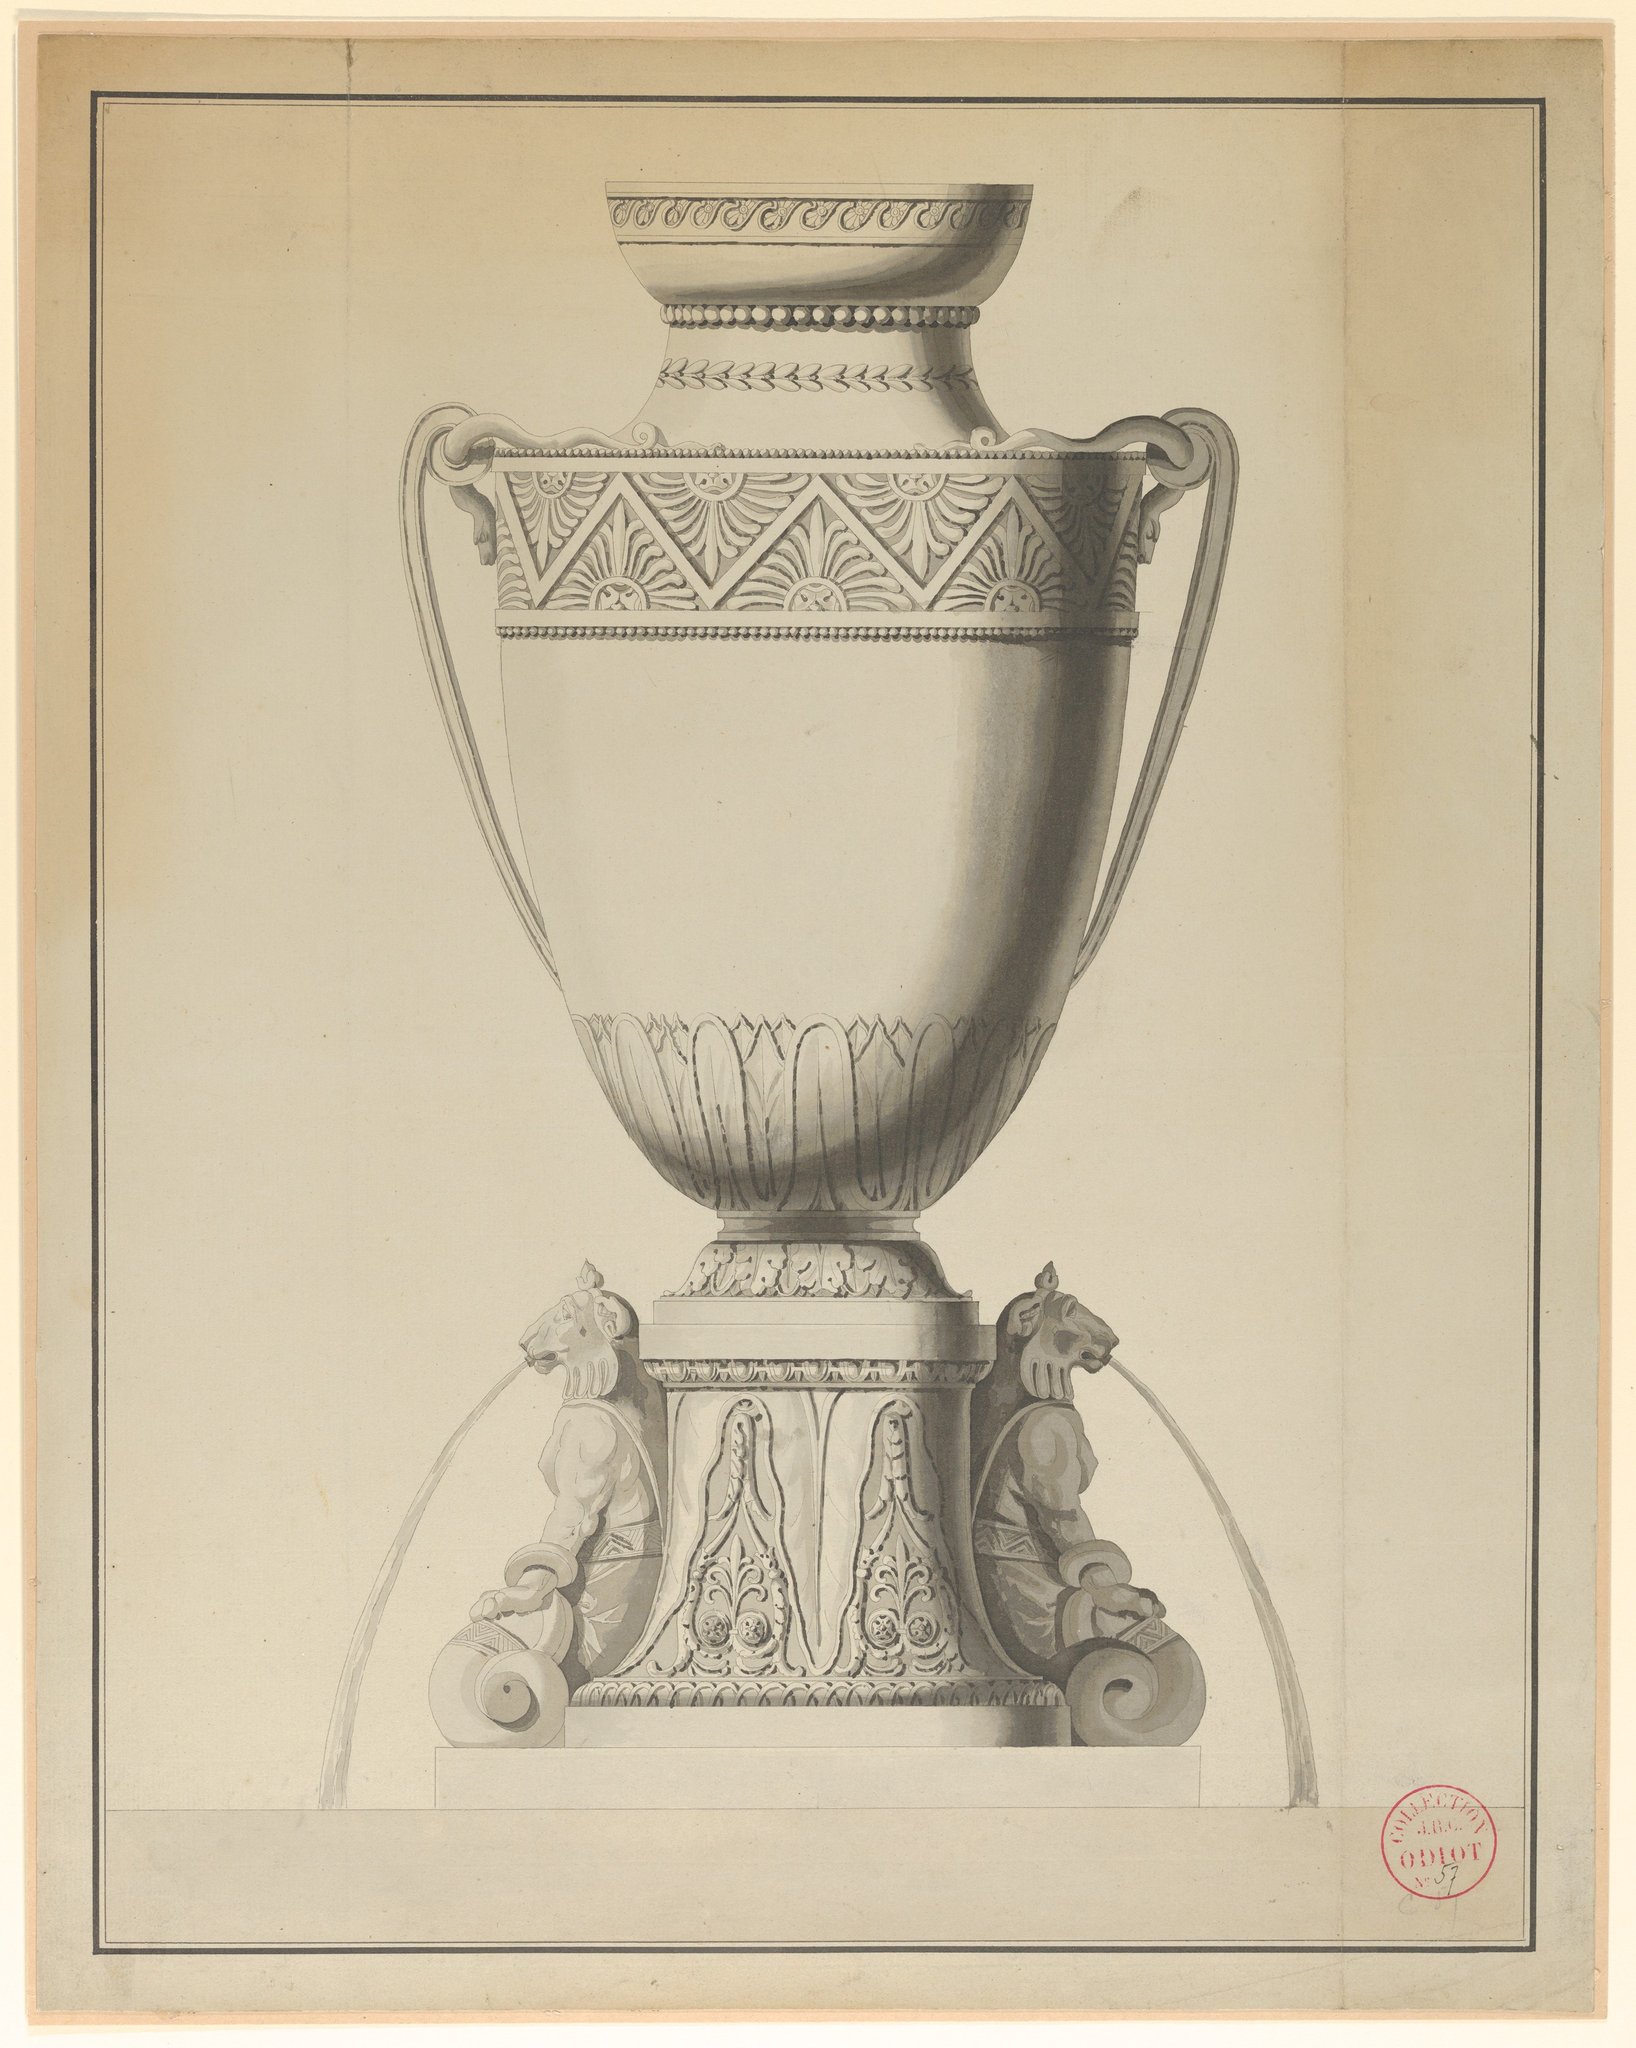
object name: drawing collection ornament architecture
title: Design for a Wine Fountain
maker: henri auguste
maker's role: artist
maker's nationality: french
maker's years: 1759-1816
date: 1770-1816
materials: ink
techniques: brush, pen, wash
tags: fountains,palmettes,lions